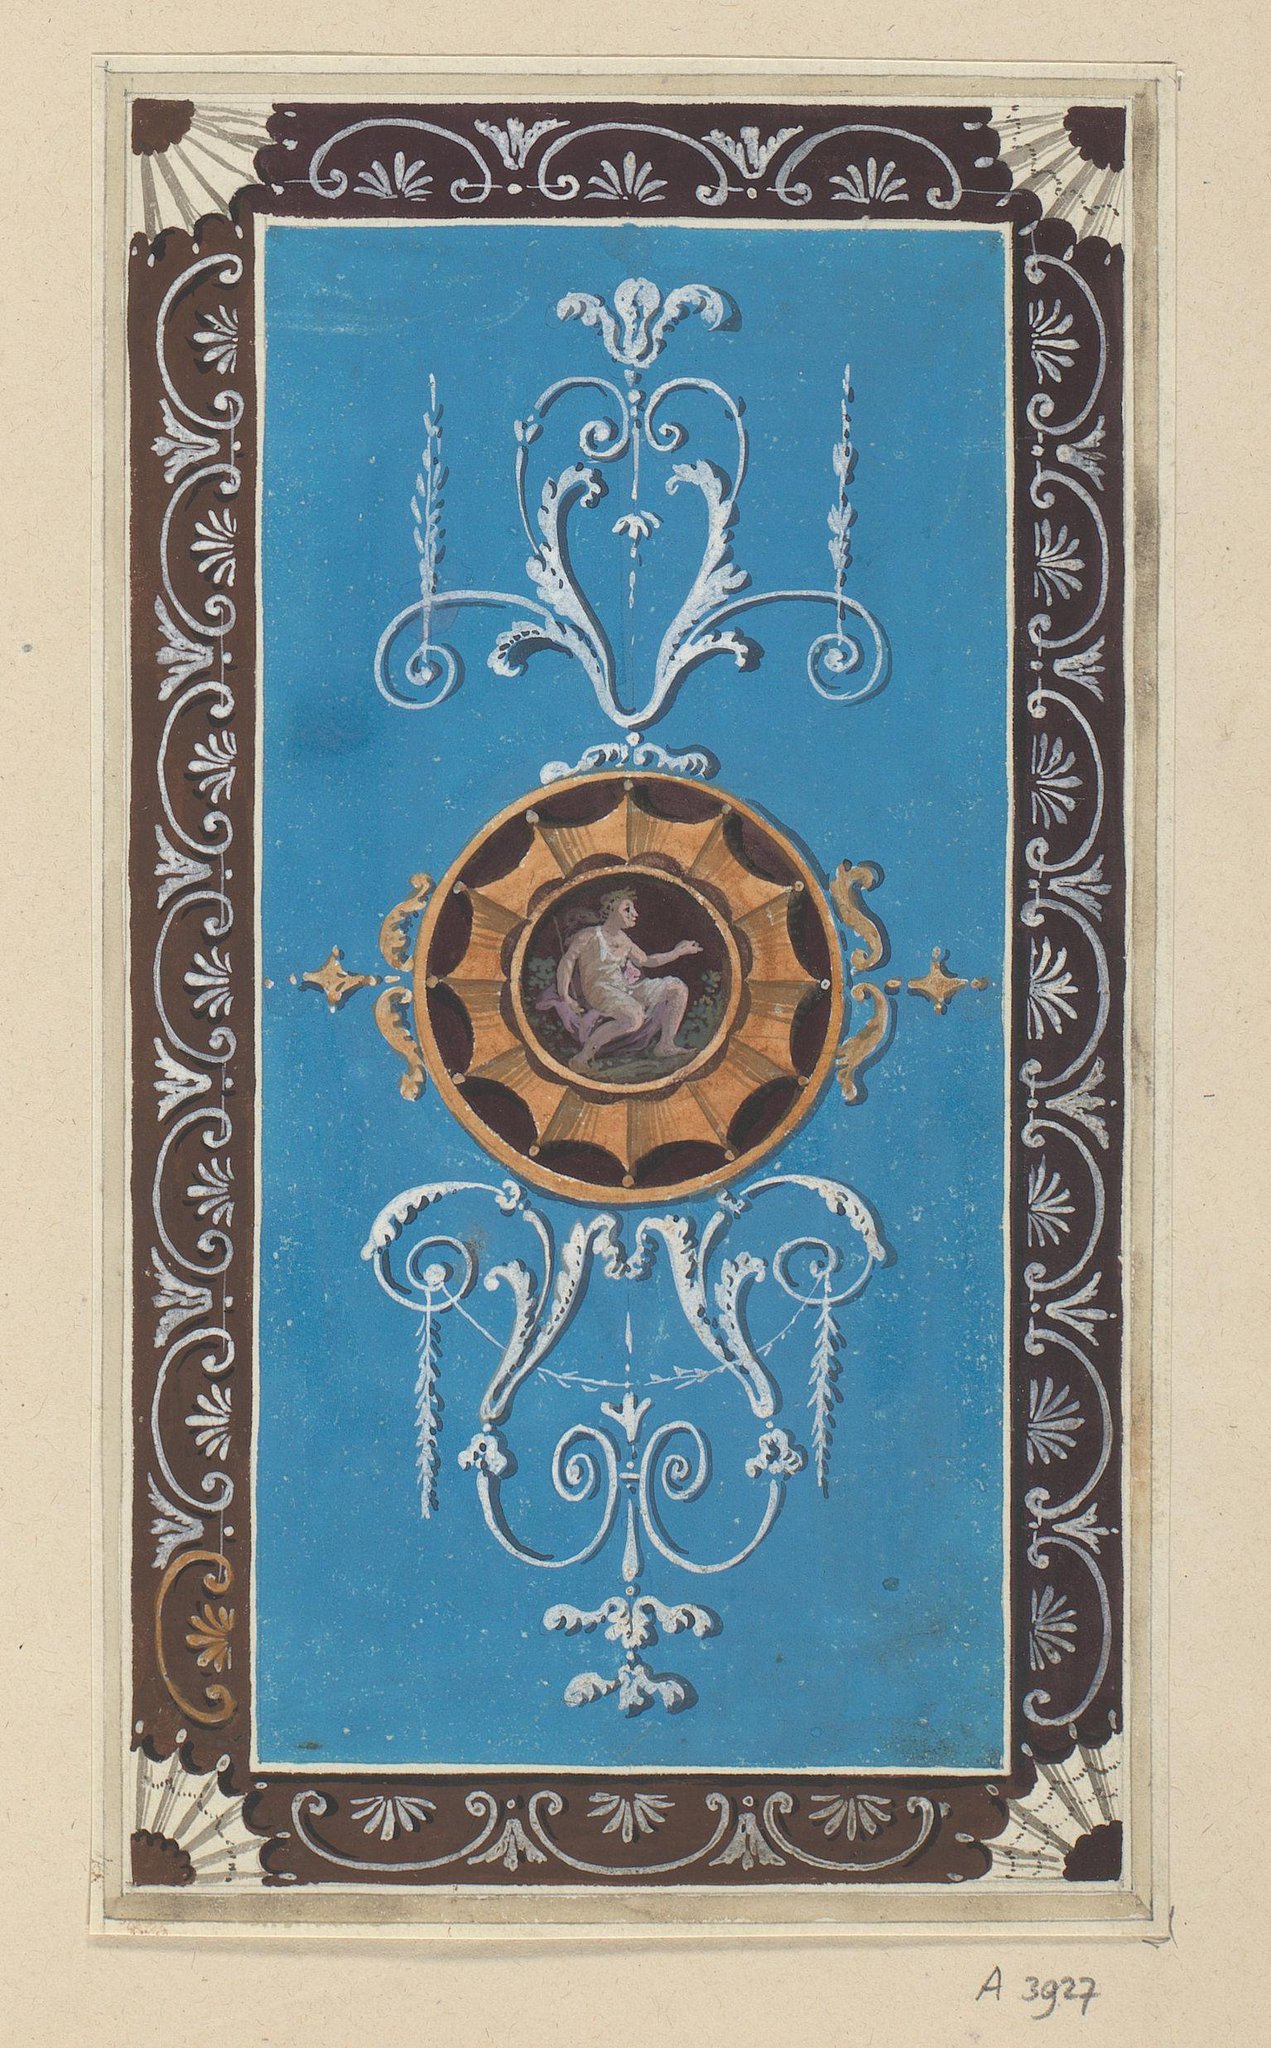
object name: drawing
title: Ontwerptekening voor een wand- of plafonddecoratie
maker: abraham van strij (i)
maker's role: draughtsman, painter, print maker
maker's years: 1753-1826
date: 1763-1826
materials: paper, pencil, watercolor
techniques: brush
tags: (decorated) ceiling, wall-covering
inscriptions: collector's mark: Lugt 2228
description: De tekeningen van Abraham van Strij zijn op een later moment ingevoegd in het album met tekeningen van Jurriaan Andriessen.